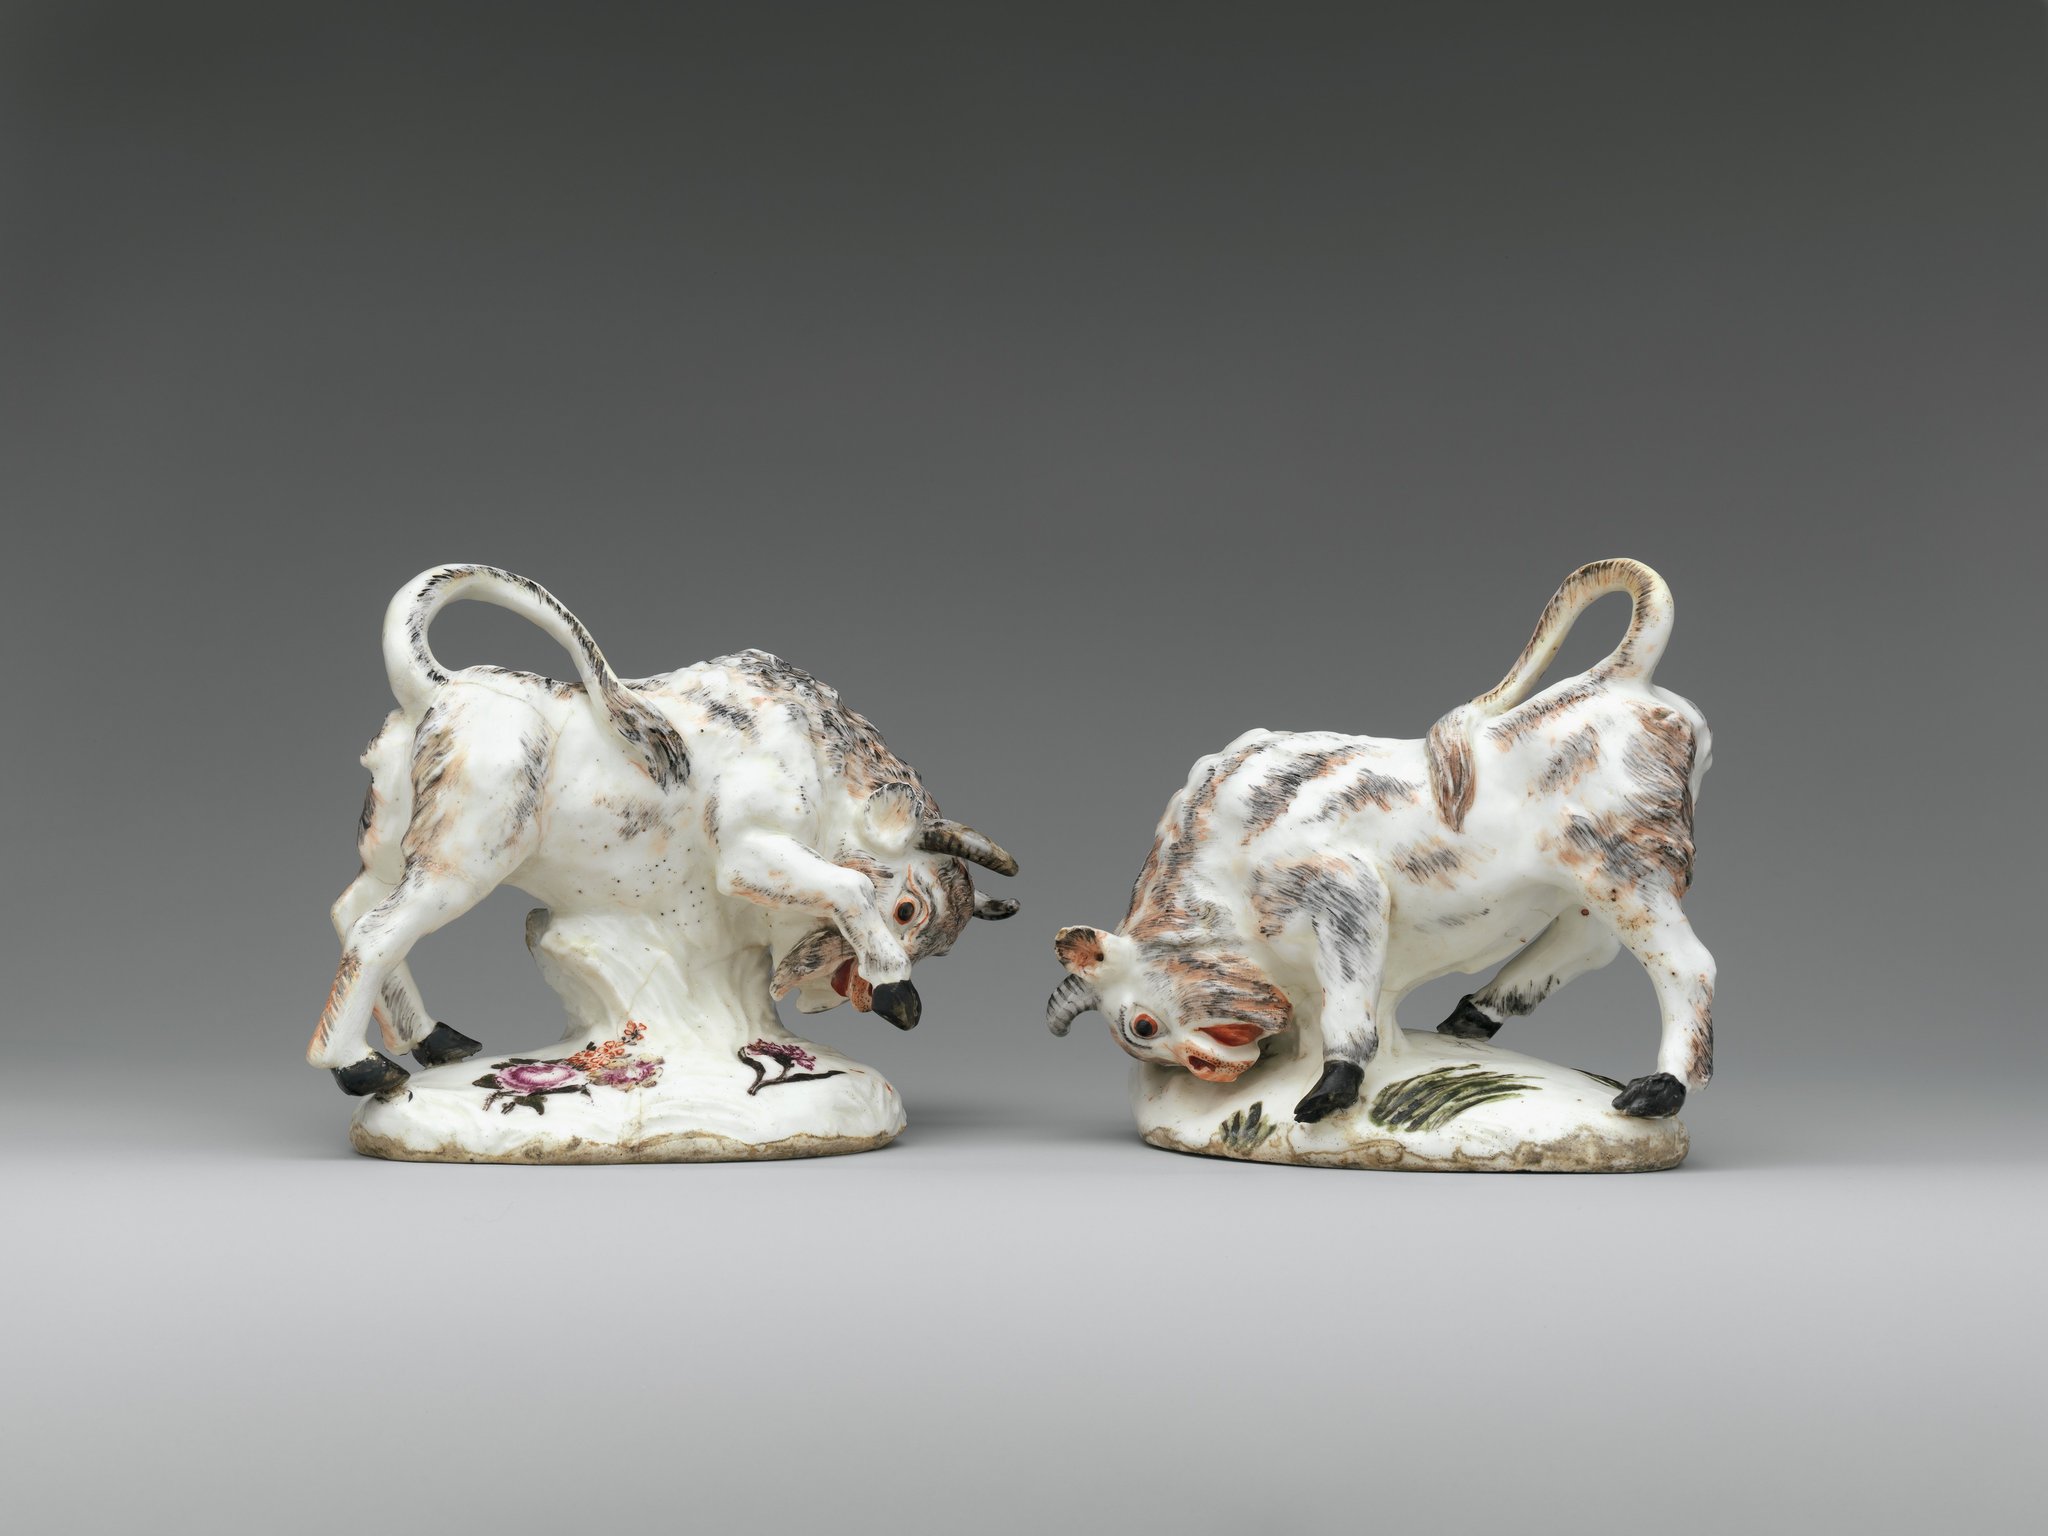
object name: figure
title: Charging bull (one of a pair)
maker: derby porcelain manufactory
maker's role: factory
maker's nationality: british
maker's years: 1751-1785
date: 1750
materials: soft paste porcelain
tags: bulls